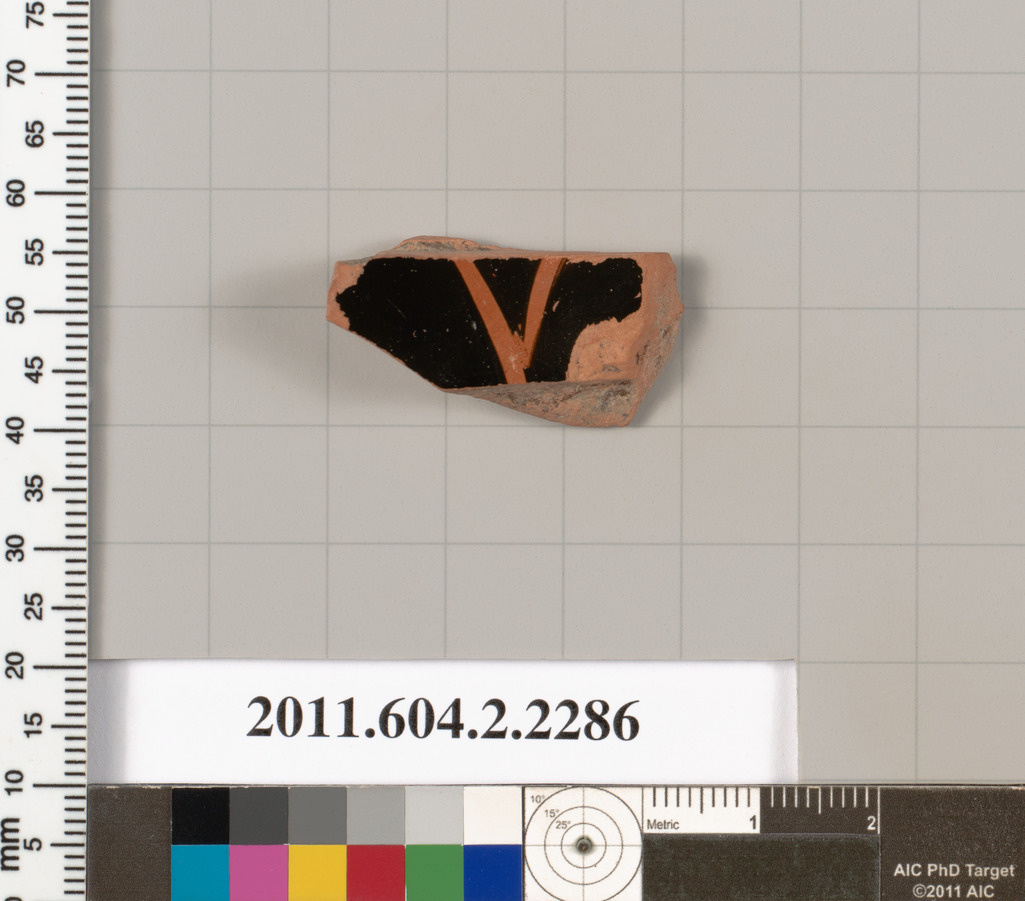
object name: pot fragment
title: Terracotta fragment of a pot; glazed on the inside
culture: greek, attic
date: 460-440 BCE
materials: terracotta